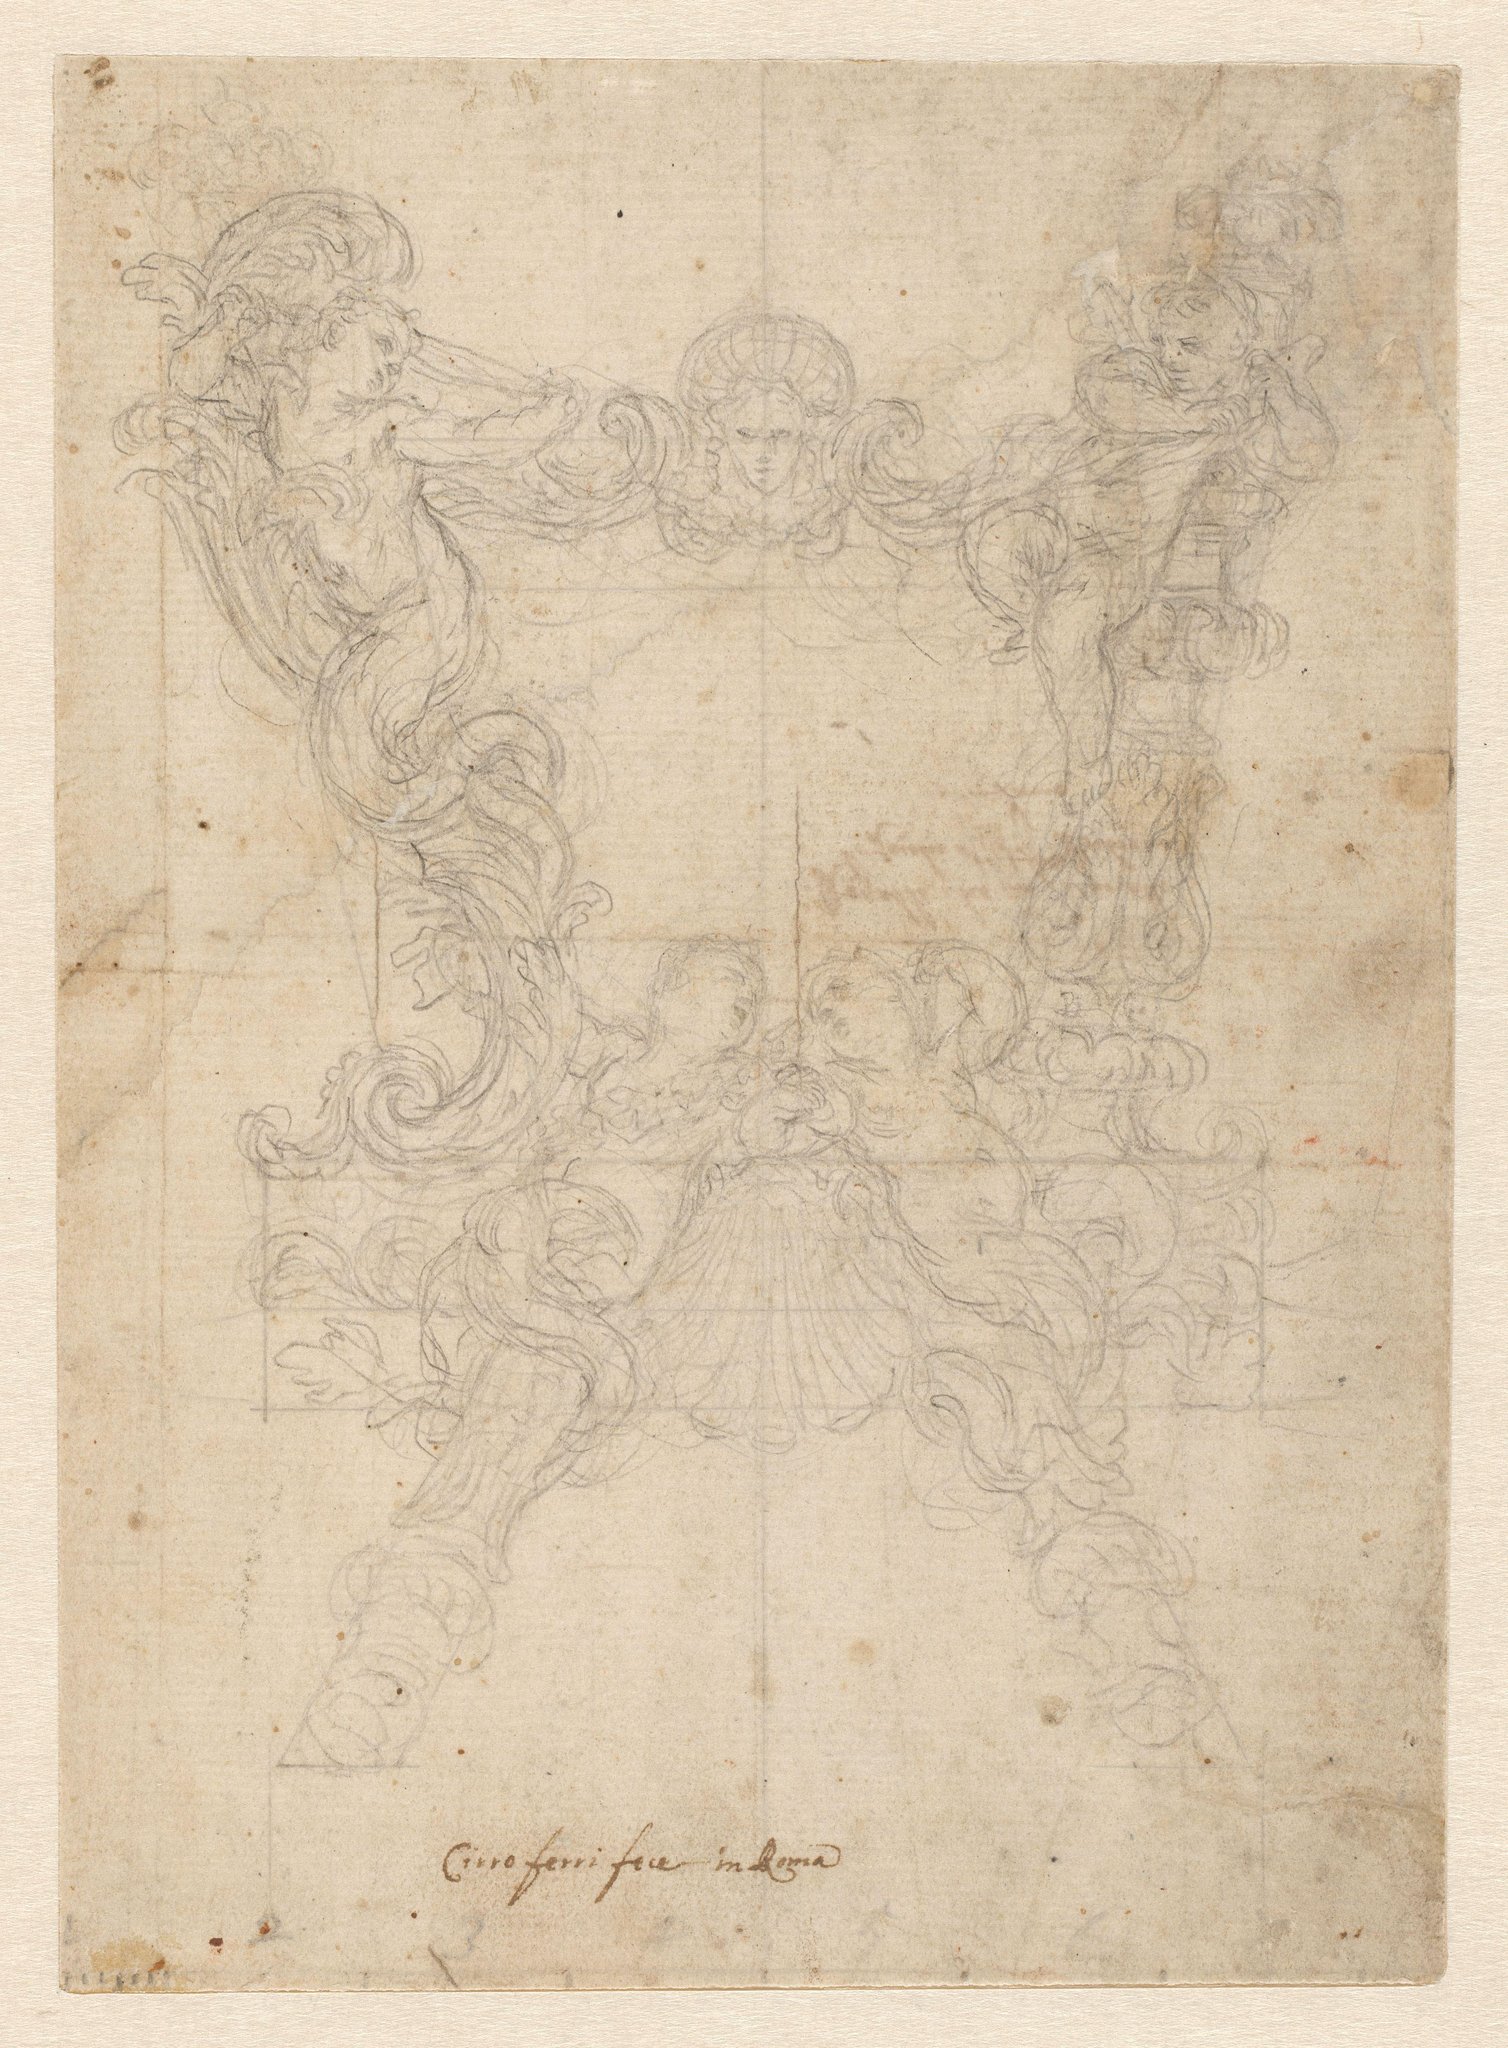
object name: design drawing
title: Ontwerp voor de achterzijde van een rijtuig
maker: ciro ferri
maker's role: draughtsman, print maker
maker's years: 1634-1689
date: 1675-1689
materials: chalk, paper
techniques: drawing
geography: rome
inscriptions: inscription: ‘Regallo che fa Marcello / Zuchi al Sig.re Bibiena / Milano’, inscription: ‘Cirro ferri fece in Roma’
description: Ontwerp voor de achterzijde van een rijtuig, met alternatieve oplossingen voor de linker- en rechterzijde, met vier naakte jongetjes, waarvan er drie dubbele visstaarten hebben.